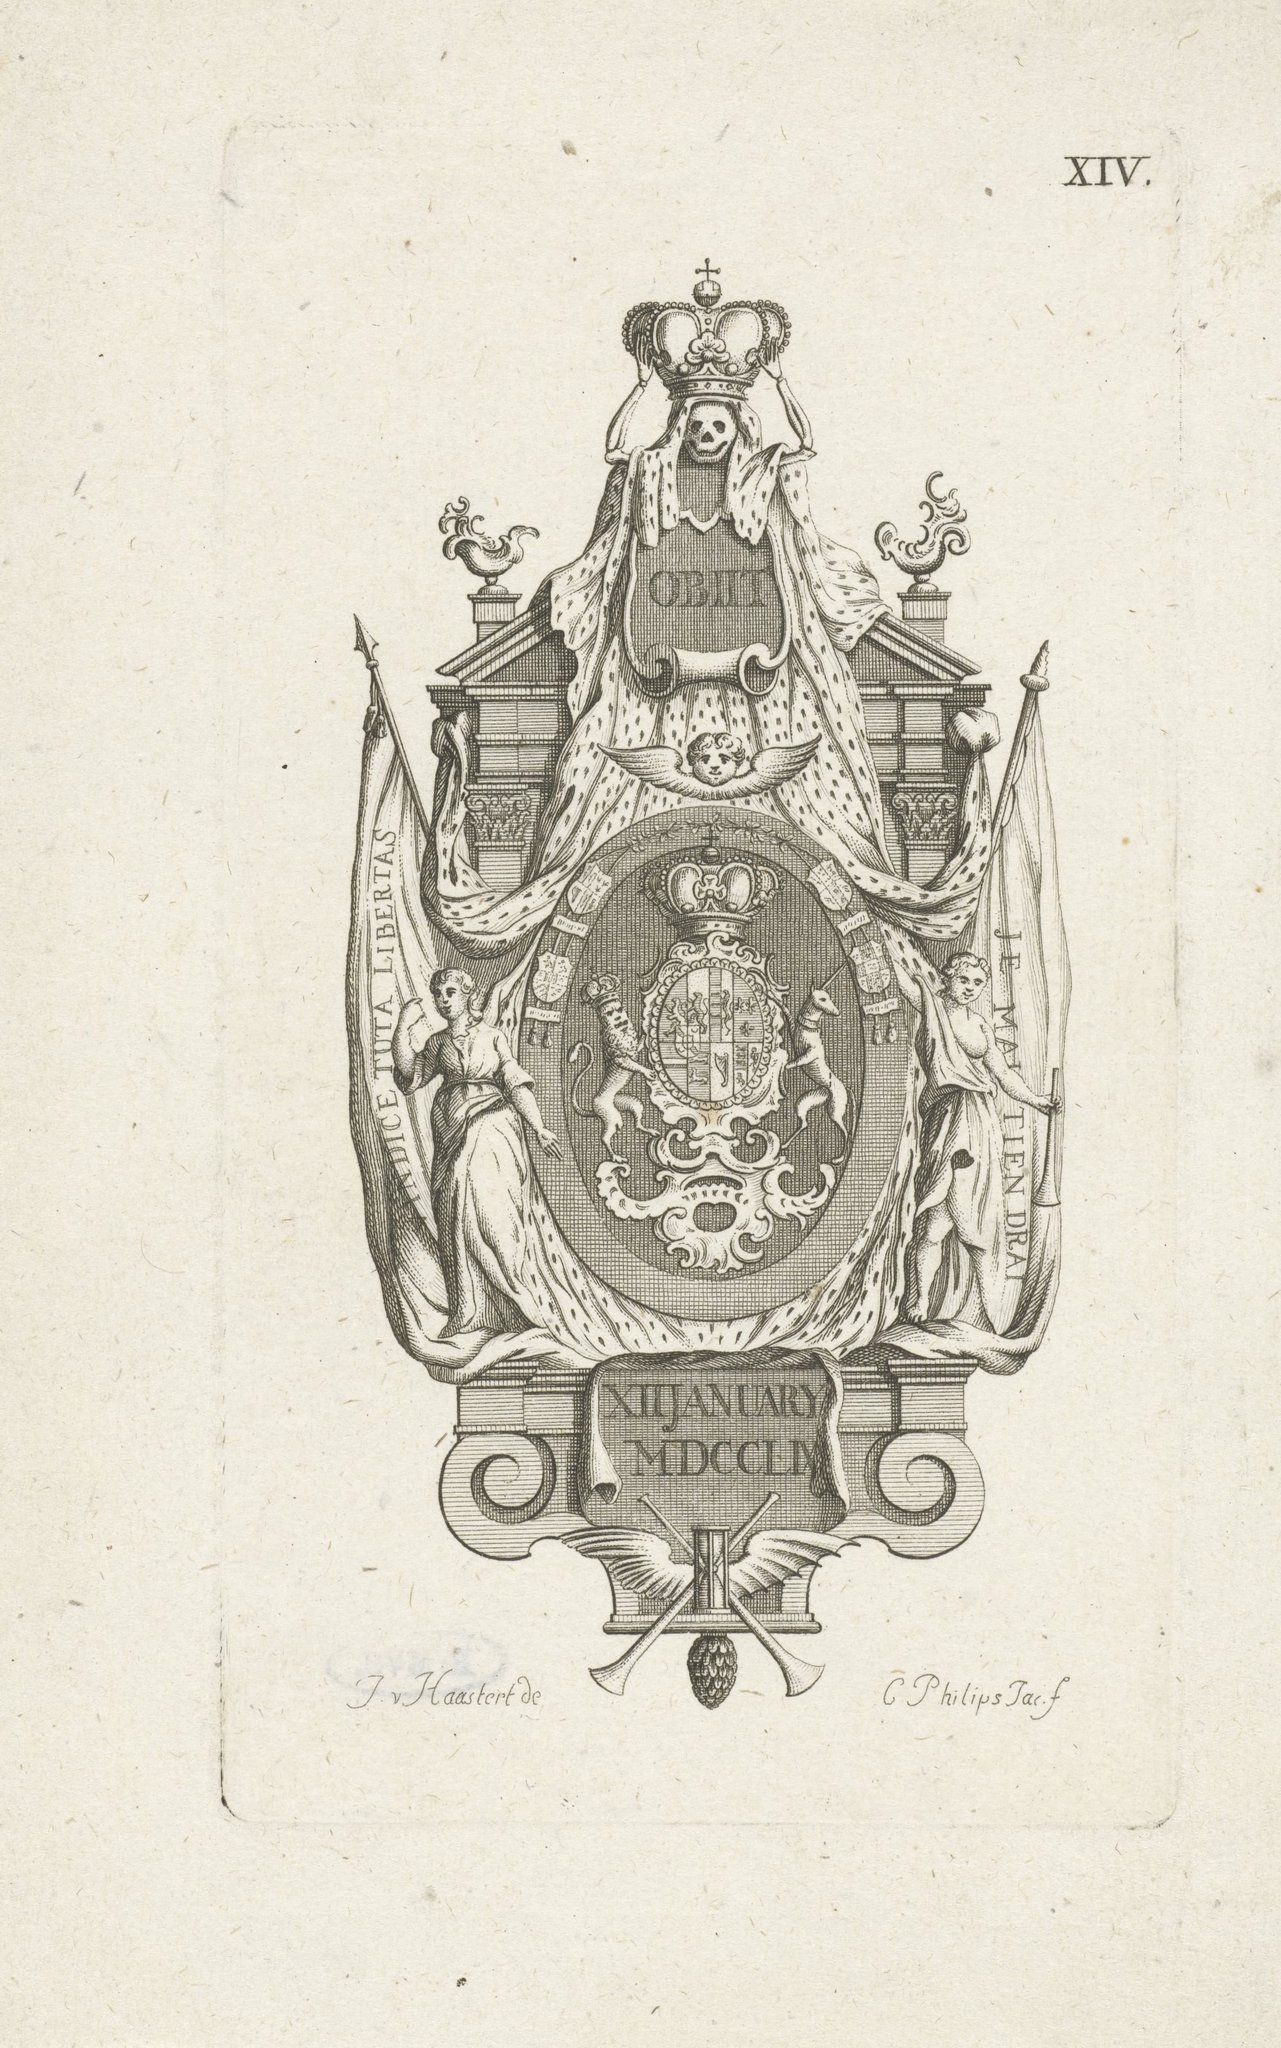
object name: print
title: Epitaaf voor de overleden prinses Anna van Hannover, 1759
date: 1752-1789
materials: paper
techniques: etching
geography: amsterdam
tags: the hague, anna van hannover, 'vanitas' symbols, epitaph, delft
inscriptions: collector's mark: Lugt 2228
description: Monument of gedenksteen voor de in 1759 overleden prinses Anna van Hannover. Monument opgebouwd uit vaandels, allegorische vrouwenfiguren en een koninklijke hermelijnen mantel, bekroond door een skelet met koningskroon. Centraal het wapen van de prinses vastgehouden door een leeuw en een eenhoorn. Rechtsboven gemerkt: XIV.